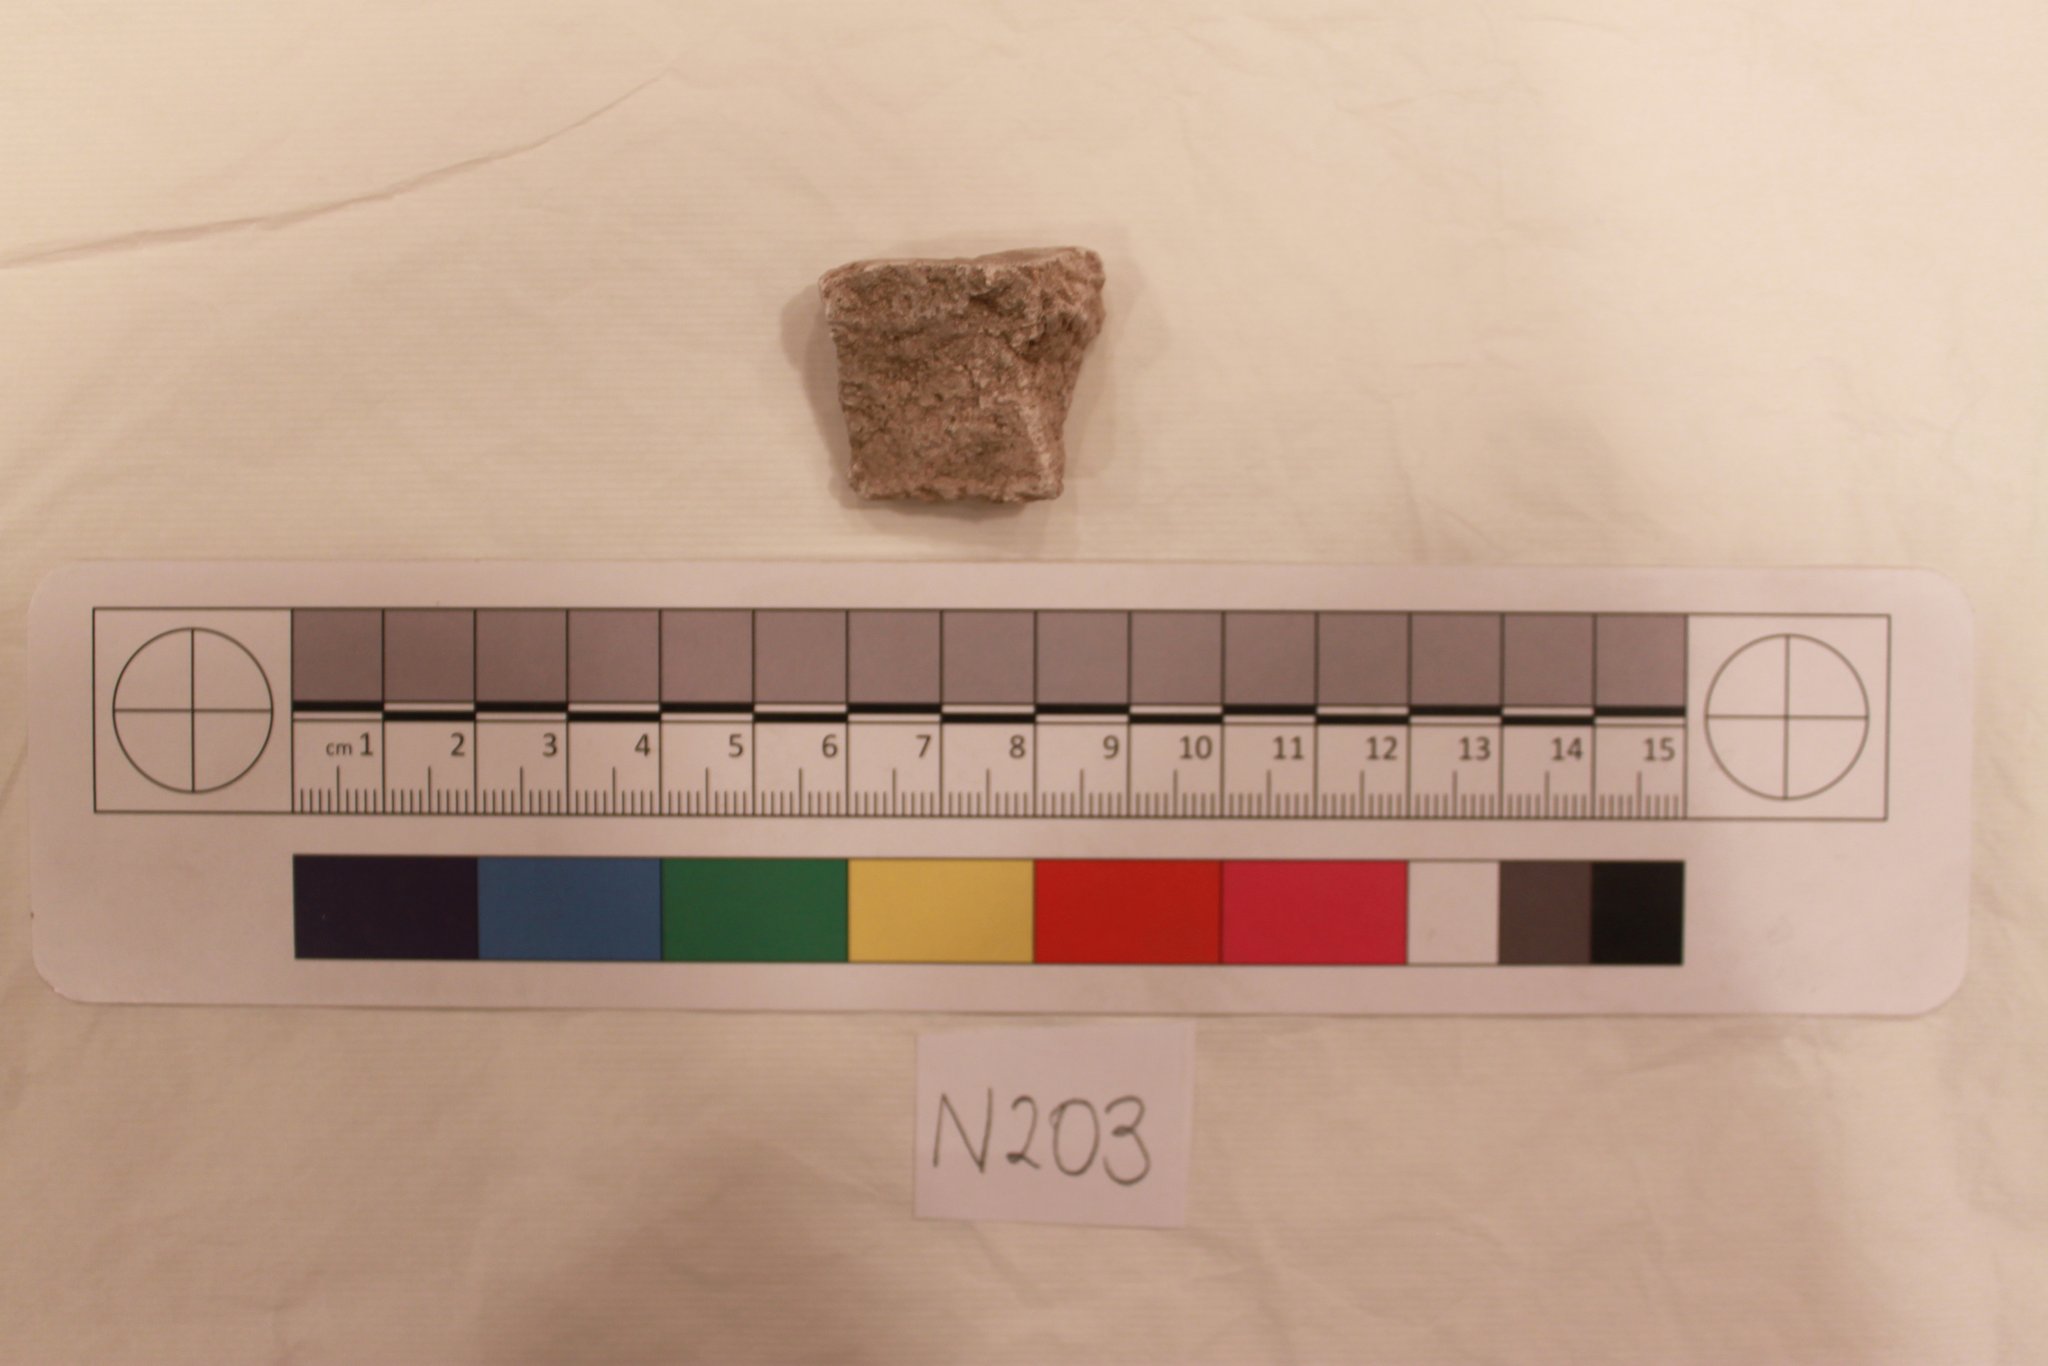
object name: fragment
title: Stucco Fragment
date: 701-1200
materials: plaster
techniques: carving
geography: iran